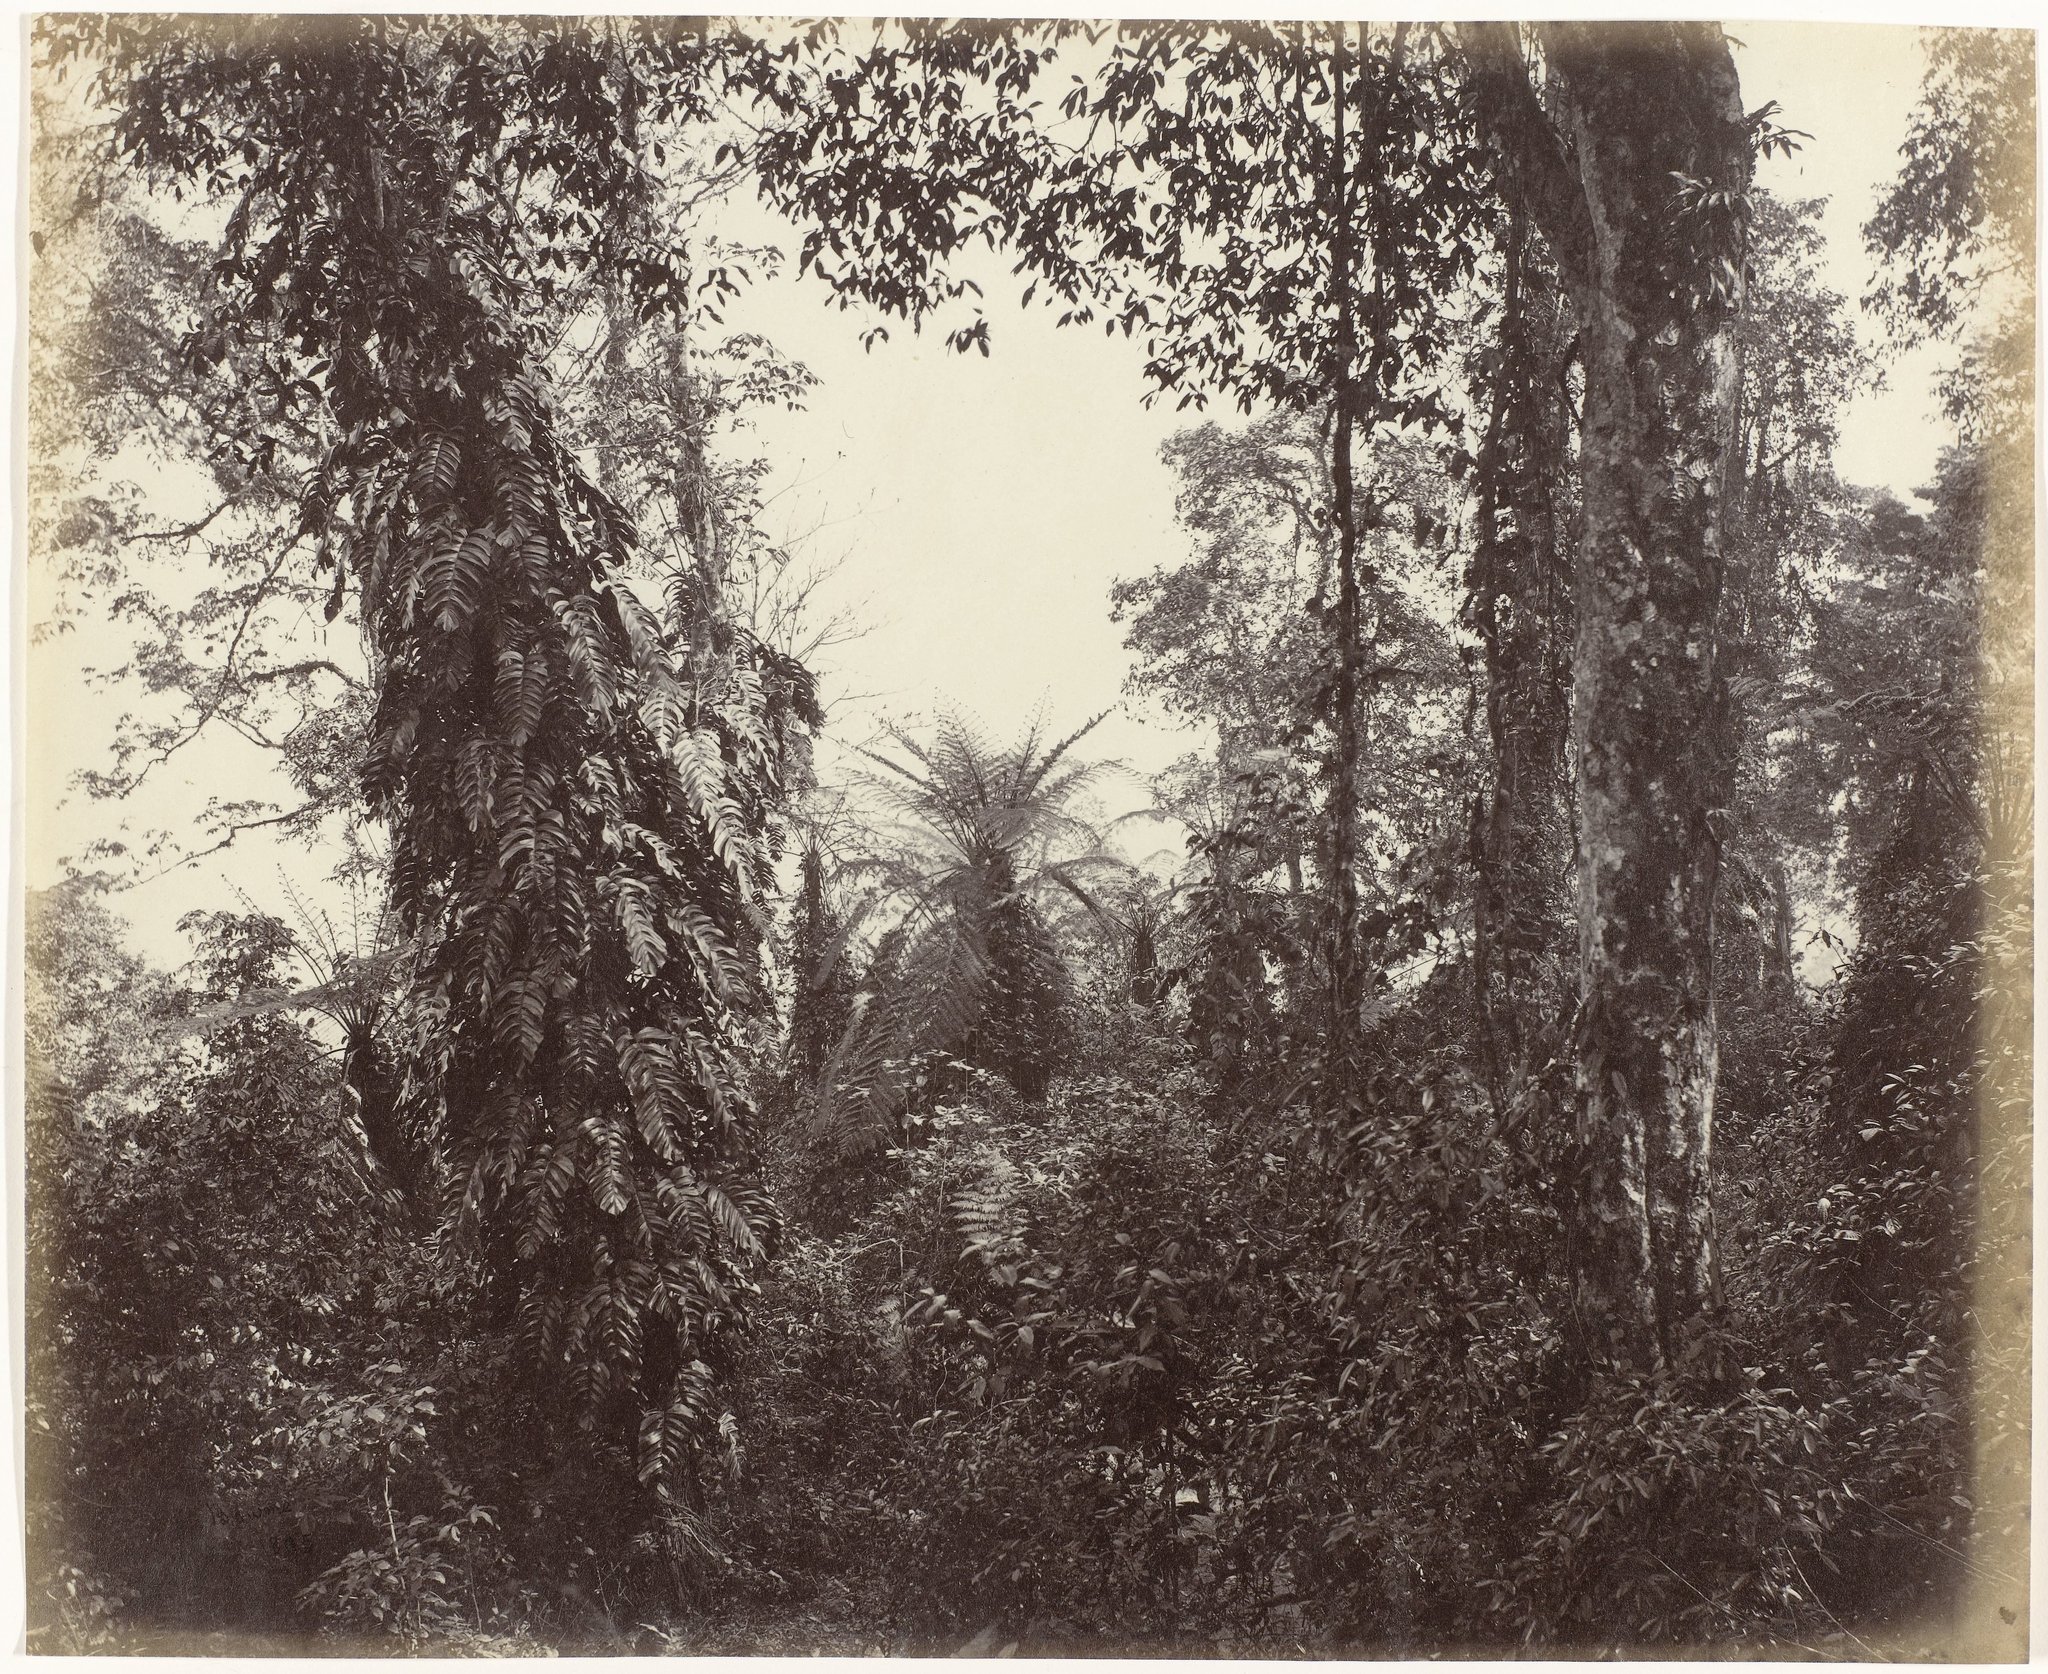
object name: photograph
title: Tree ferns near Darjeeling, West Bengal, India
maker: samuel bourne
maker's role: fotograaf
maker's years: 1834-1912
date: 1868-1869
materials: paper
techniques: albumen print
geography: darjeeling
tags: trees, ferns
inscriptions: number: ‘1895’, name: ‘Bourne’, number: ‘1895’